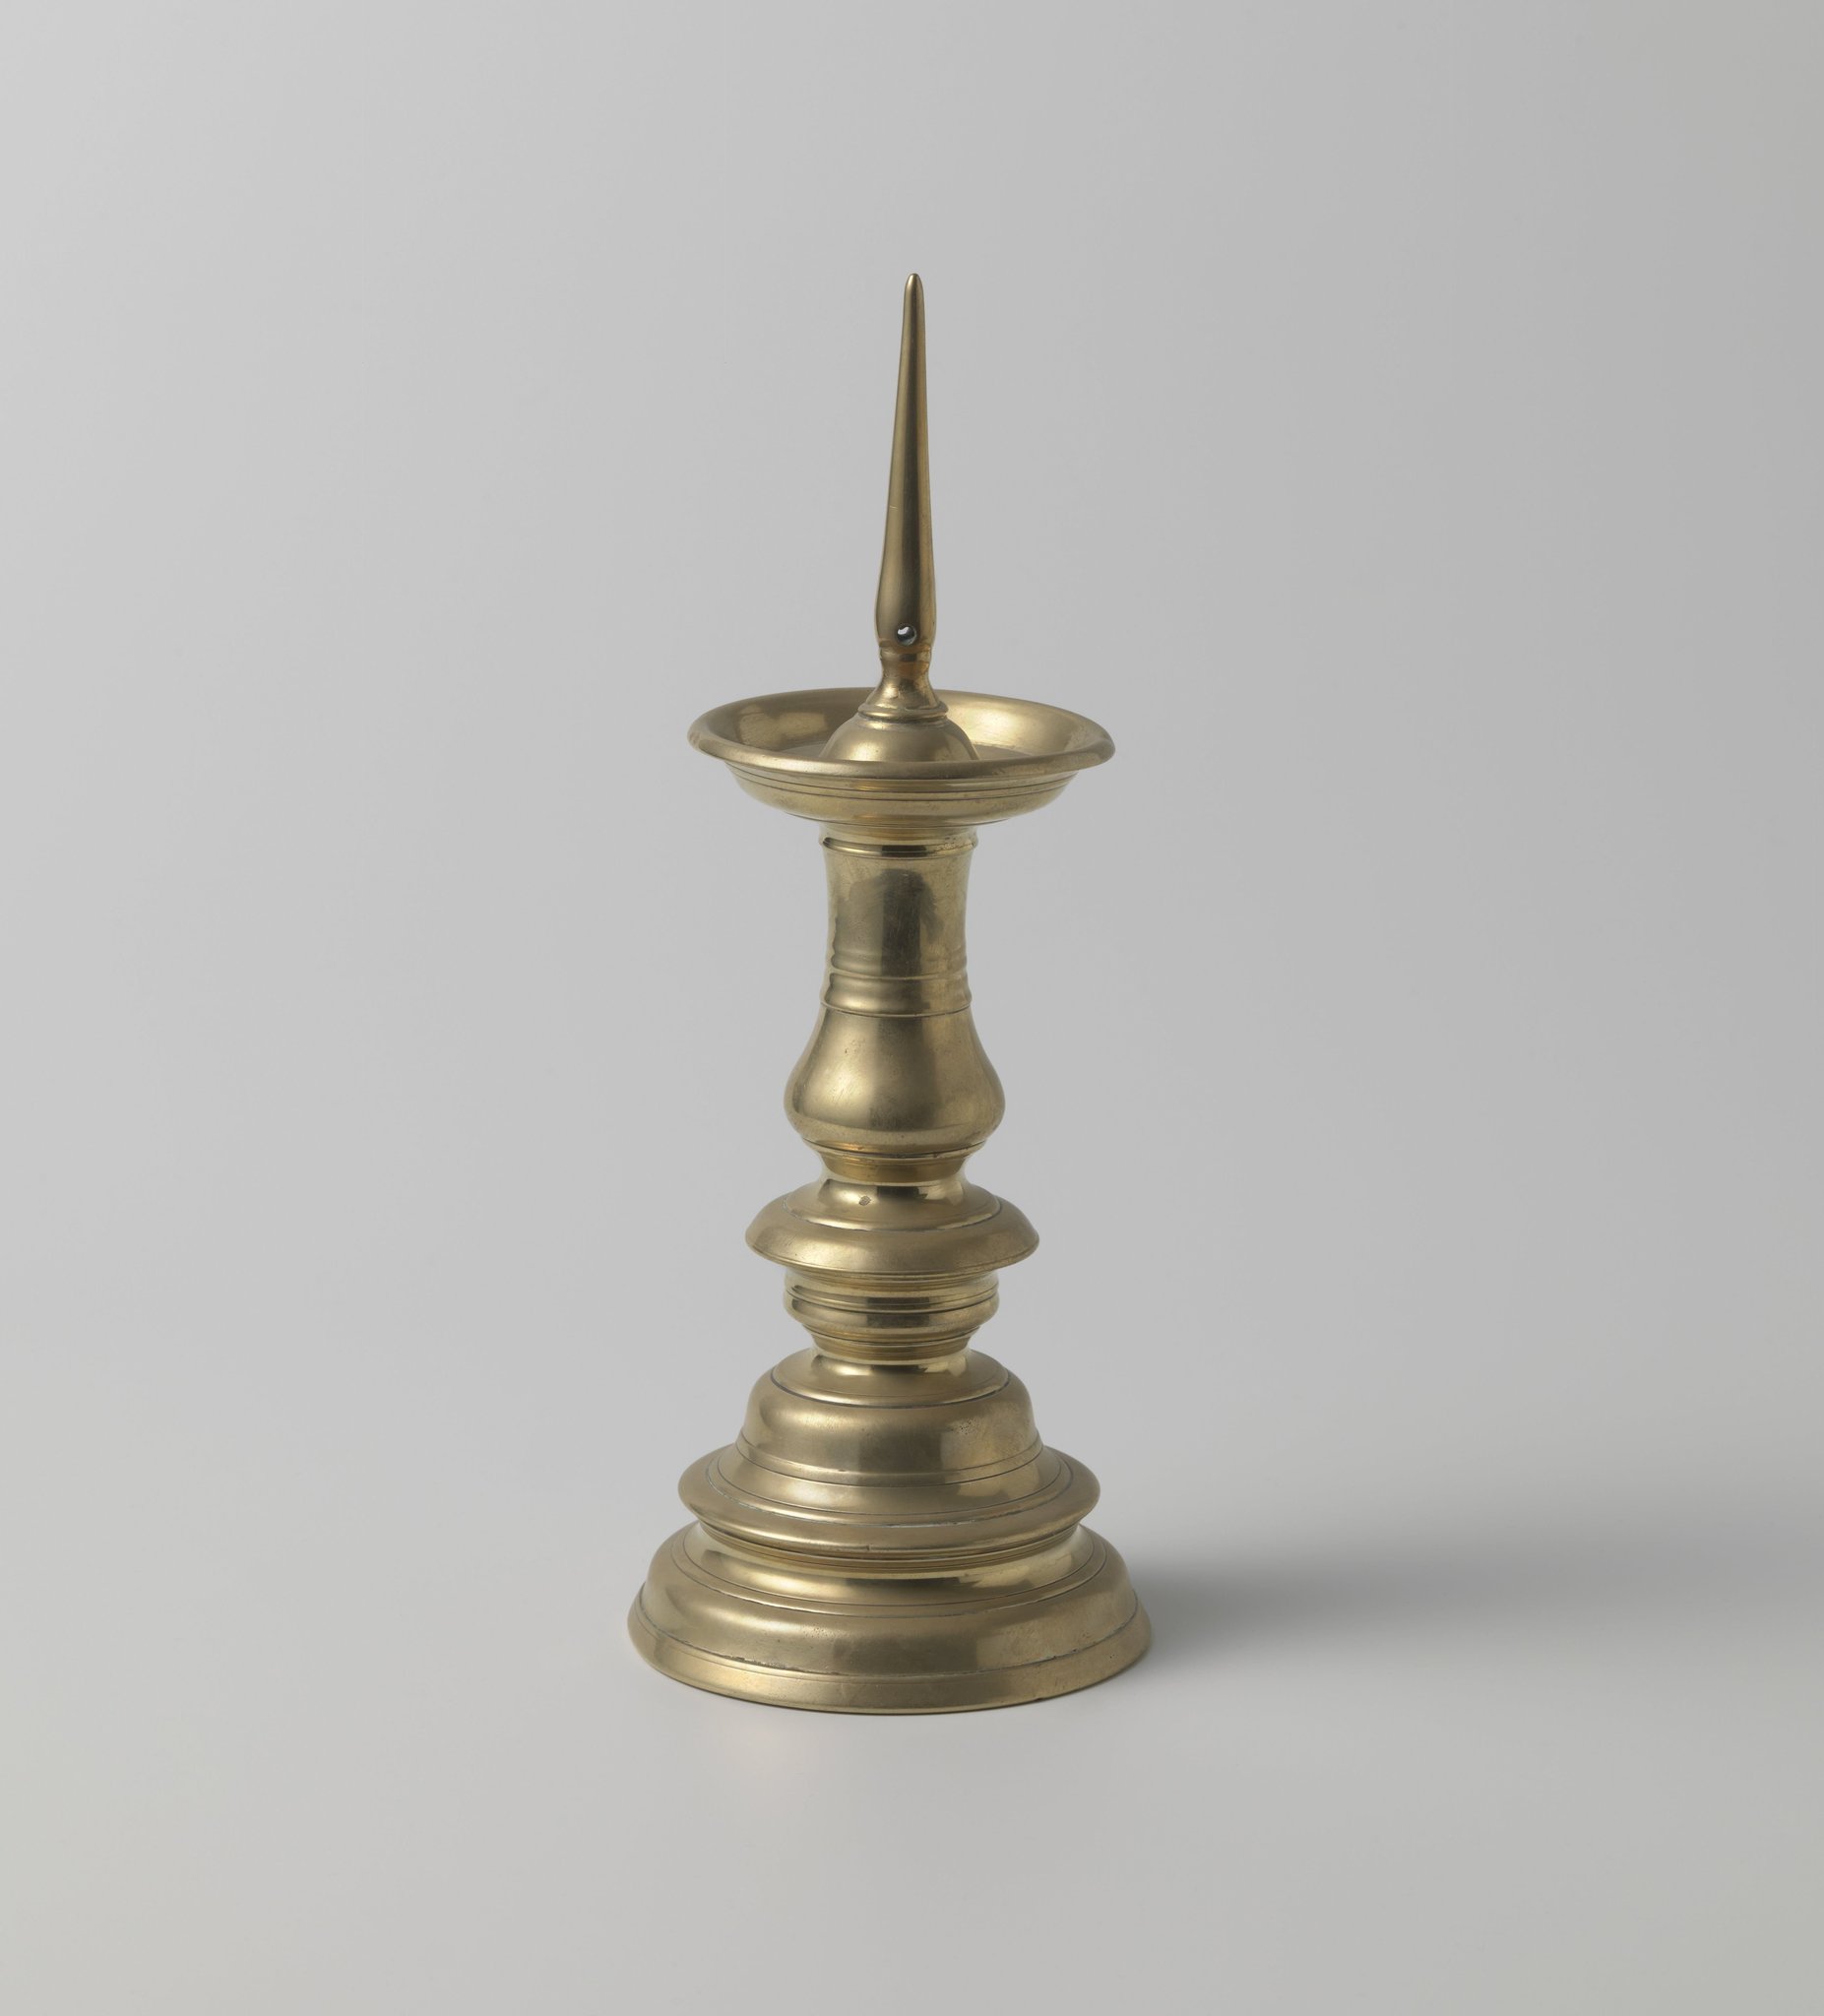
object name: candlestick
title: Kandelaar van messing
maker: Anonymous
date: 1600-1699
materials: brass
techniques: casting, riveted, turning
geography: nuremberg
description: Voet, stam en vetvanger zijn in één geheel gegoten. De kaarsenpin is met de bodem van de vetvanger op twee plaatsen in de vetvanger geklonken. De geprofileerde pin heeft onderaan een horizontaal gat. De geprofileerde konische voet gaat over in een stam, die bovenaan balustervormig is, en vervolgens in een geprofileerde vetvanger. Alle onderdelen zijn met ringen versierd, de baluster tevens met rillen. Voet en stam zijn van binnen hol. De standring van de voet is aan de binnenkant afgedraaid.